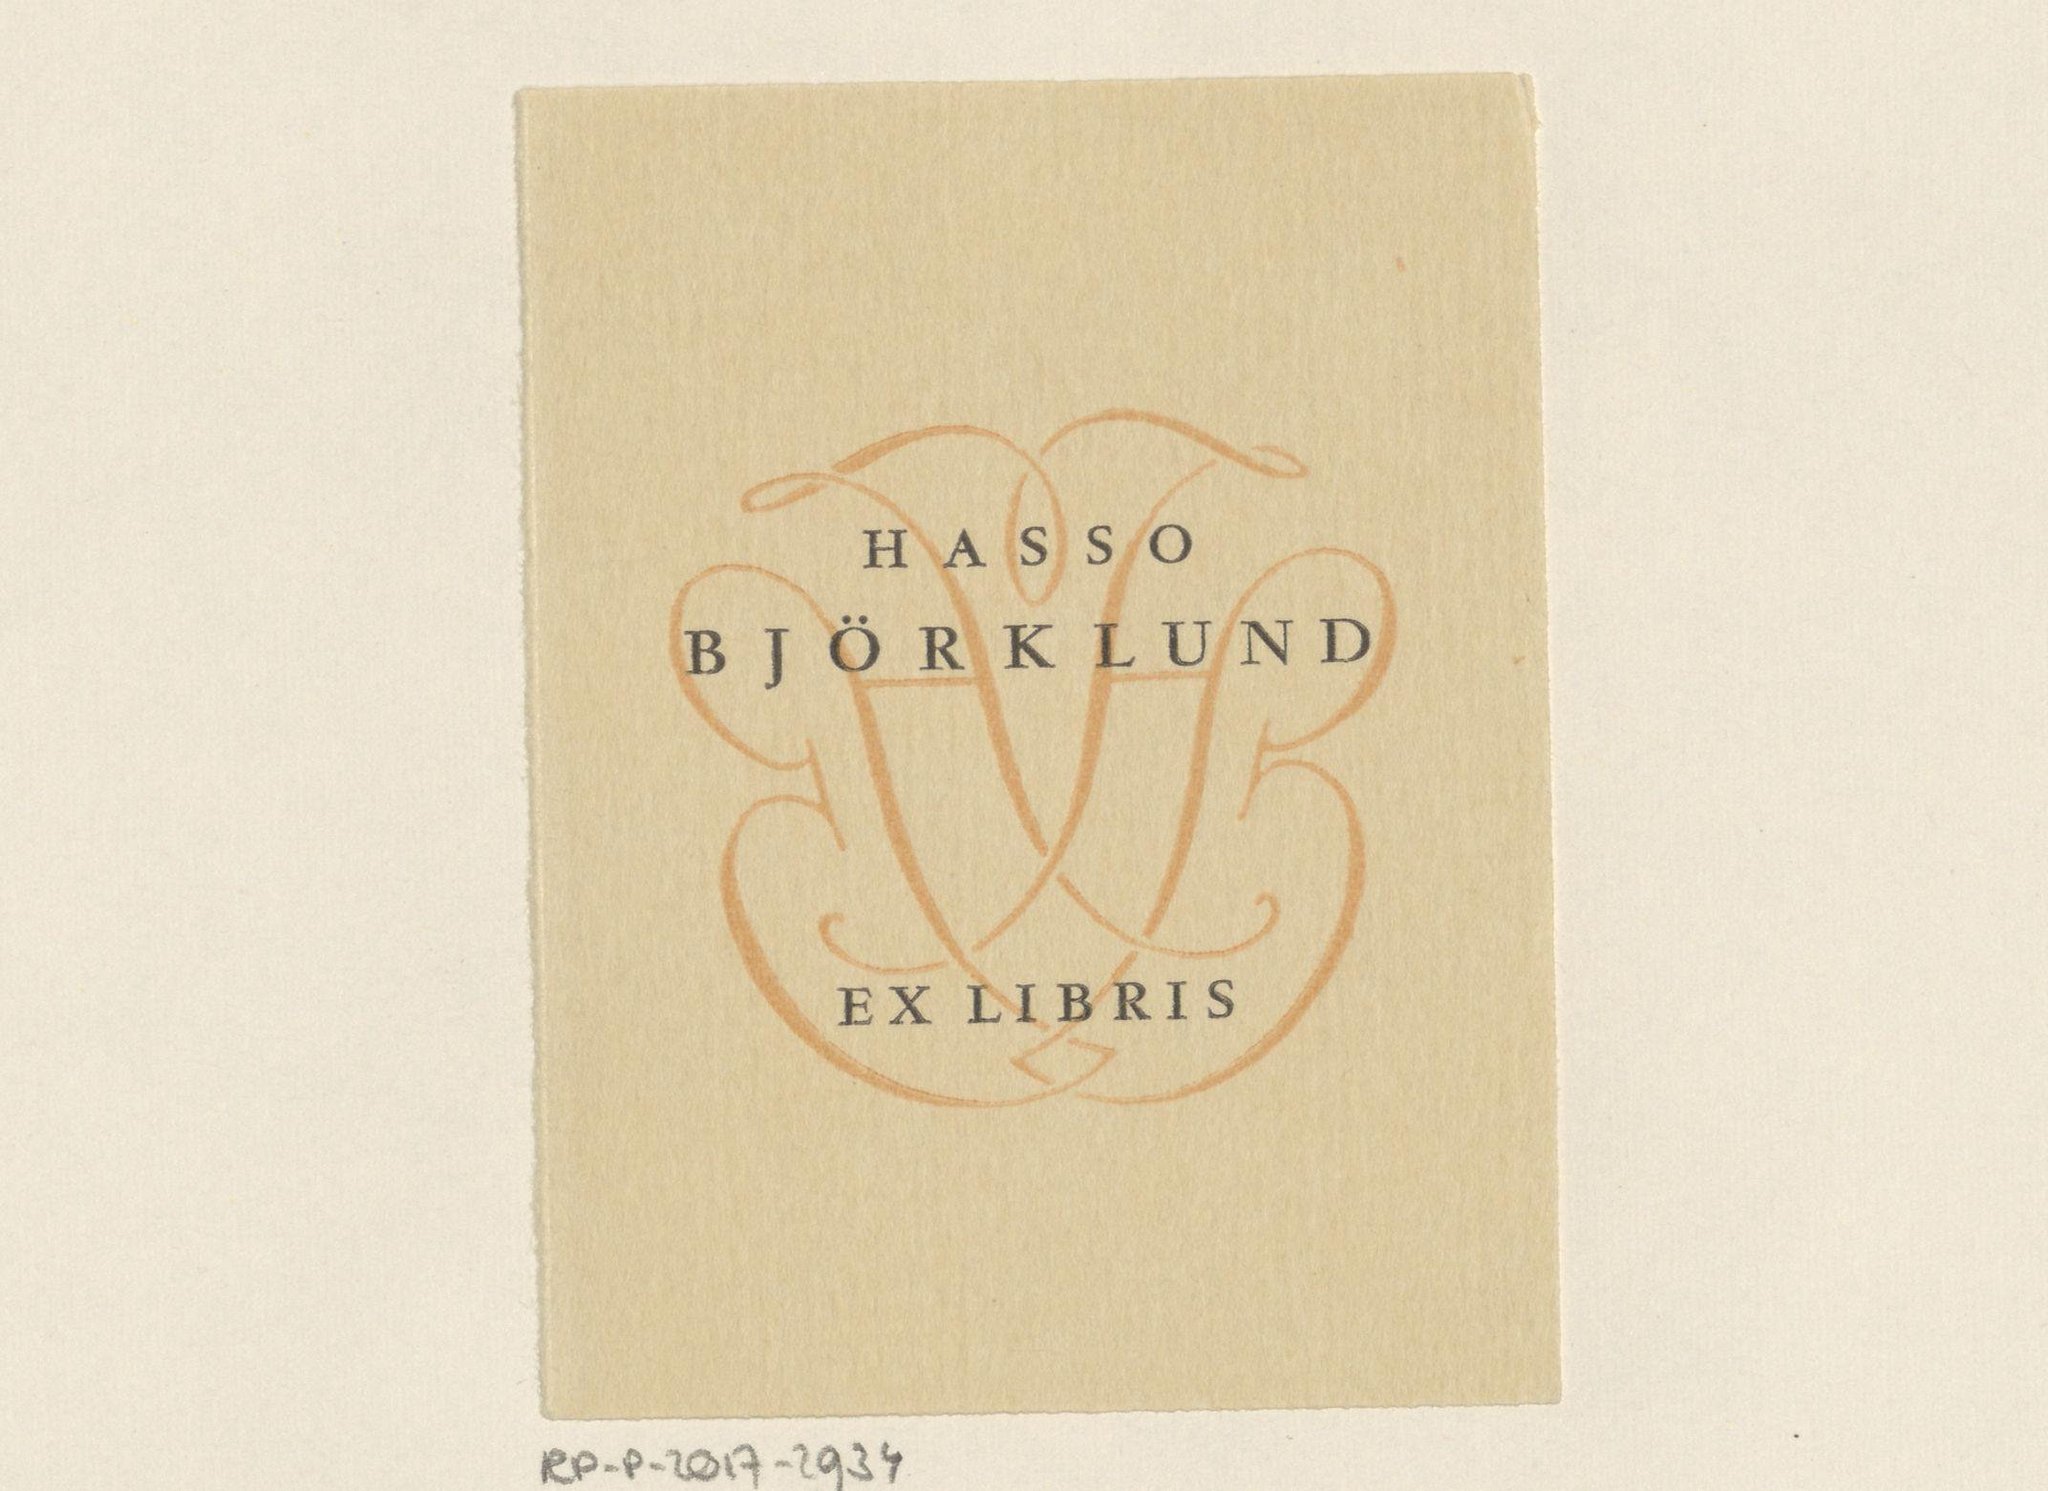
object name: bookplate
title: Ex libris van Hasso Björklund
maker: Anonymous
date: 1900-1999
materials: paper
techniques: printing block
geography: sweden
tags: hasso björklund